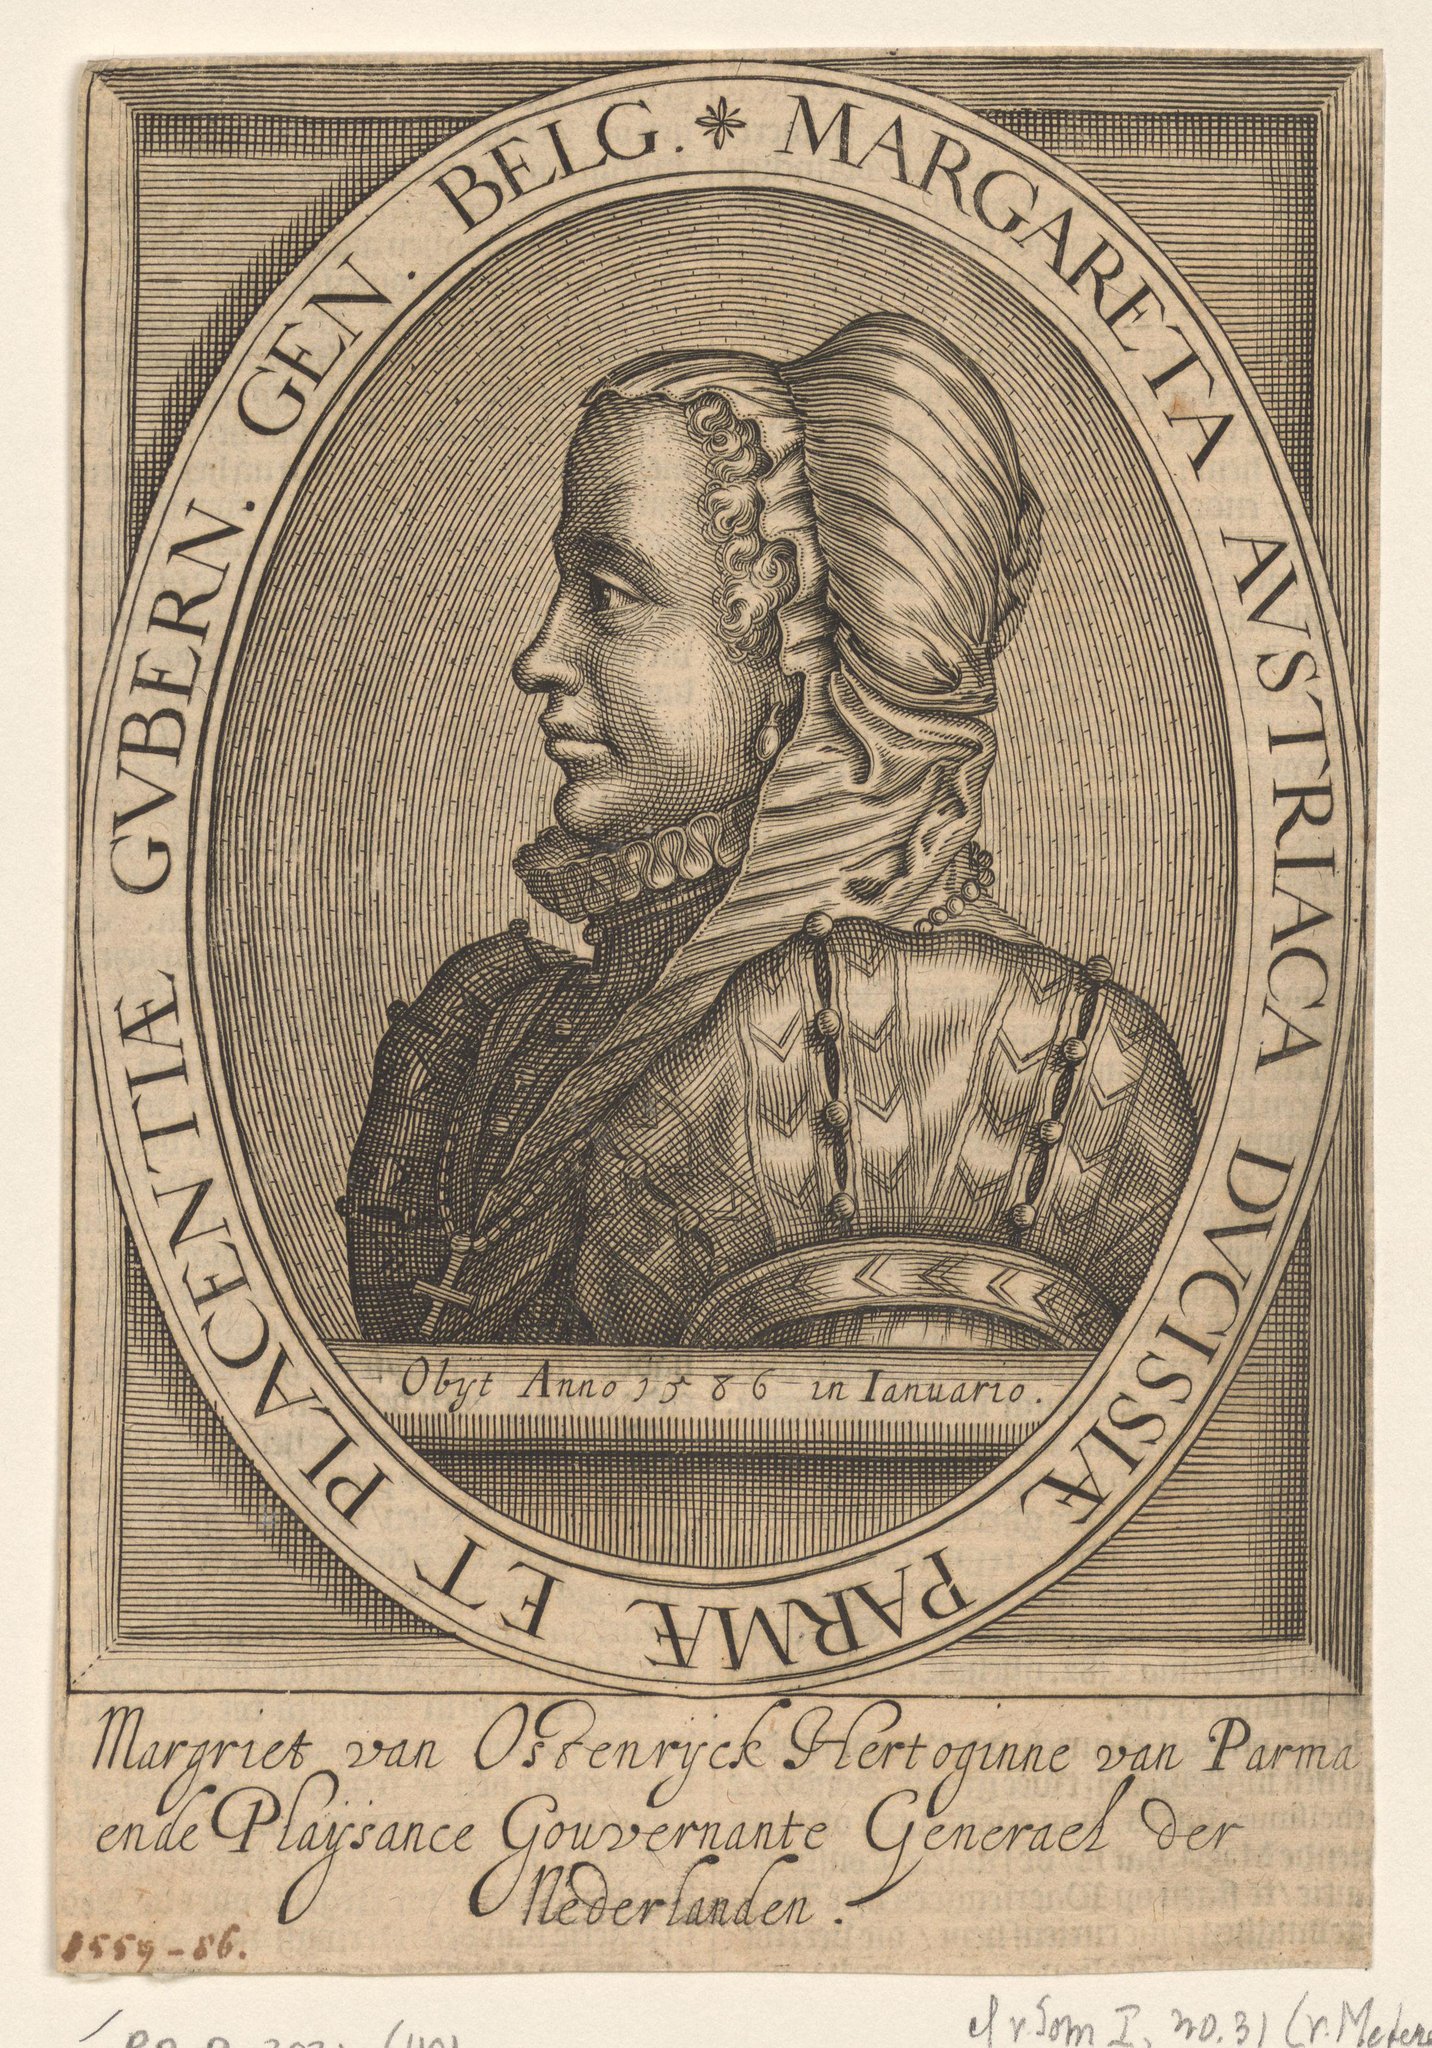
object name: book illustration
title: Portret van Margaretha van Parma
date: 1614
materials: paper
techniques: engraving, letterpress printing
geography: the hague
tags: historical persons - bb - woman, ornament ~ medallion, regent, substitute ruler; viceroy - bb - female ruler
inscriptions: collector's mark: Lugt 2228, inscription: ‘1559-86’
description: Prent uit: Meteren, Emanuel van. Historie der Neder-landscher ende haerder Na-buren Oorlogen (...). Den Haag: Hillebrant Jacobsz. van Wouw, 1614.